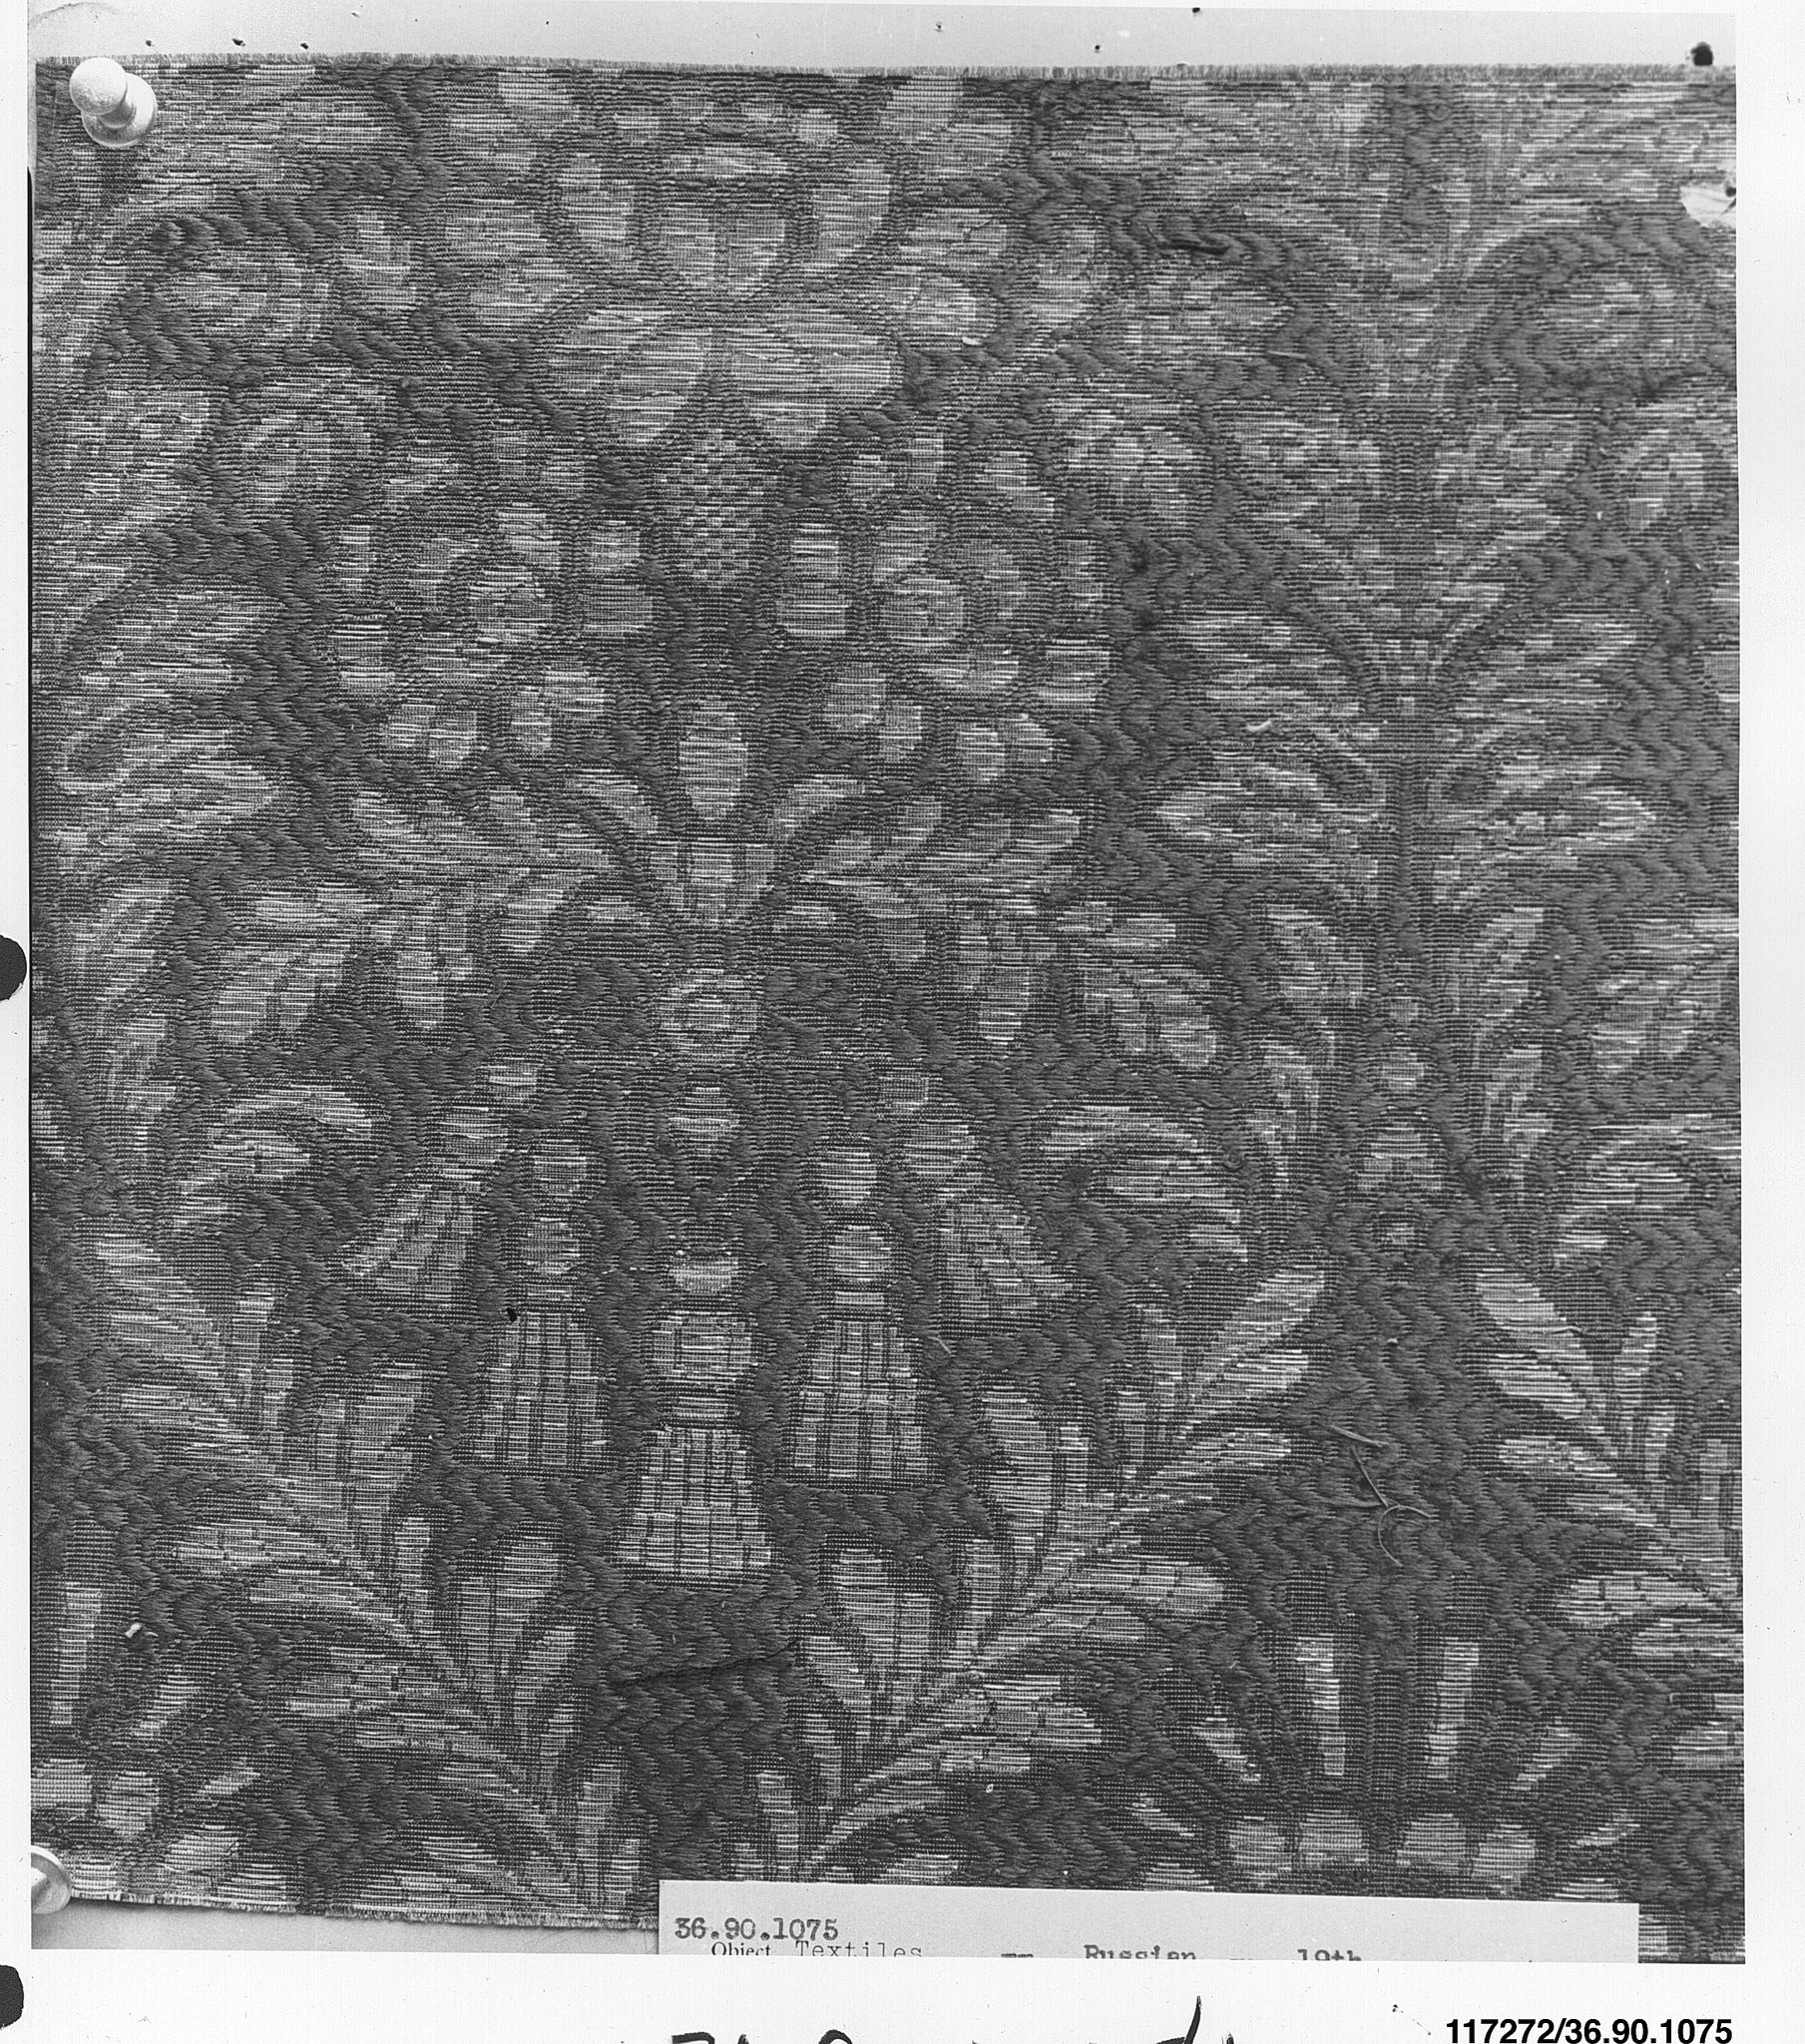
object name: piece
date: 1801-1900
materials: metal thread, silk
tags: flowers,leaves